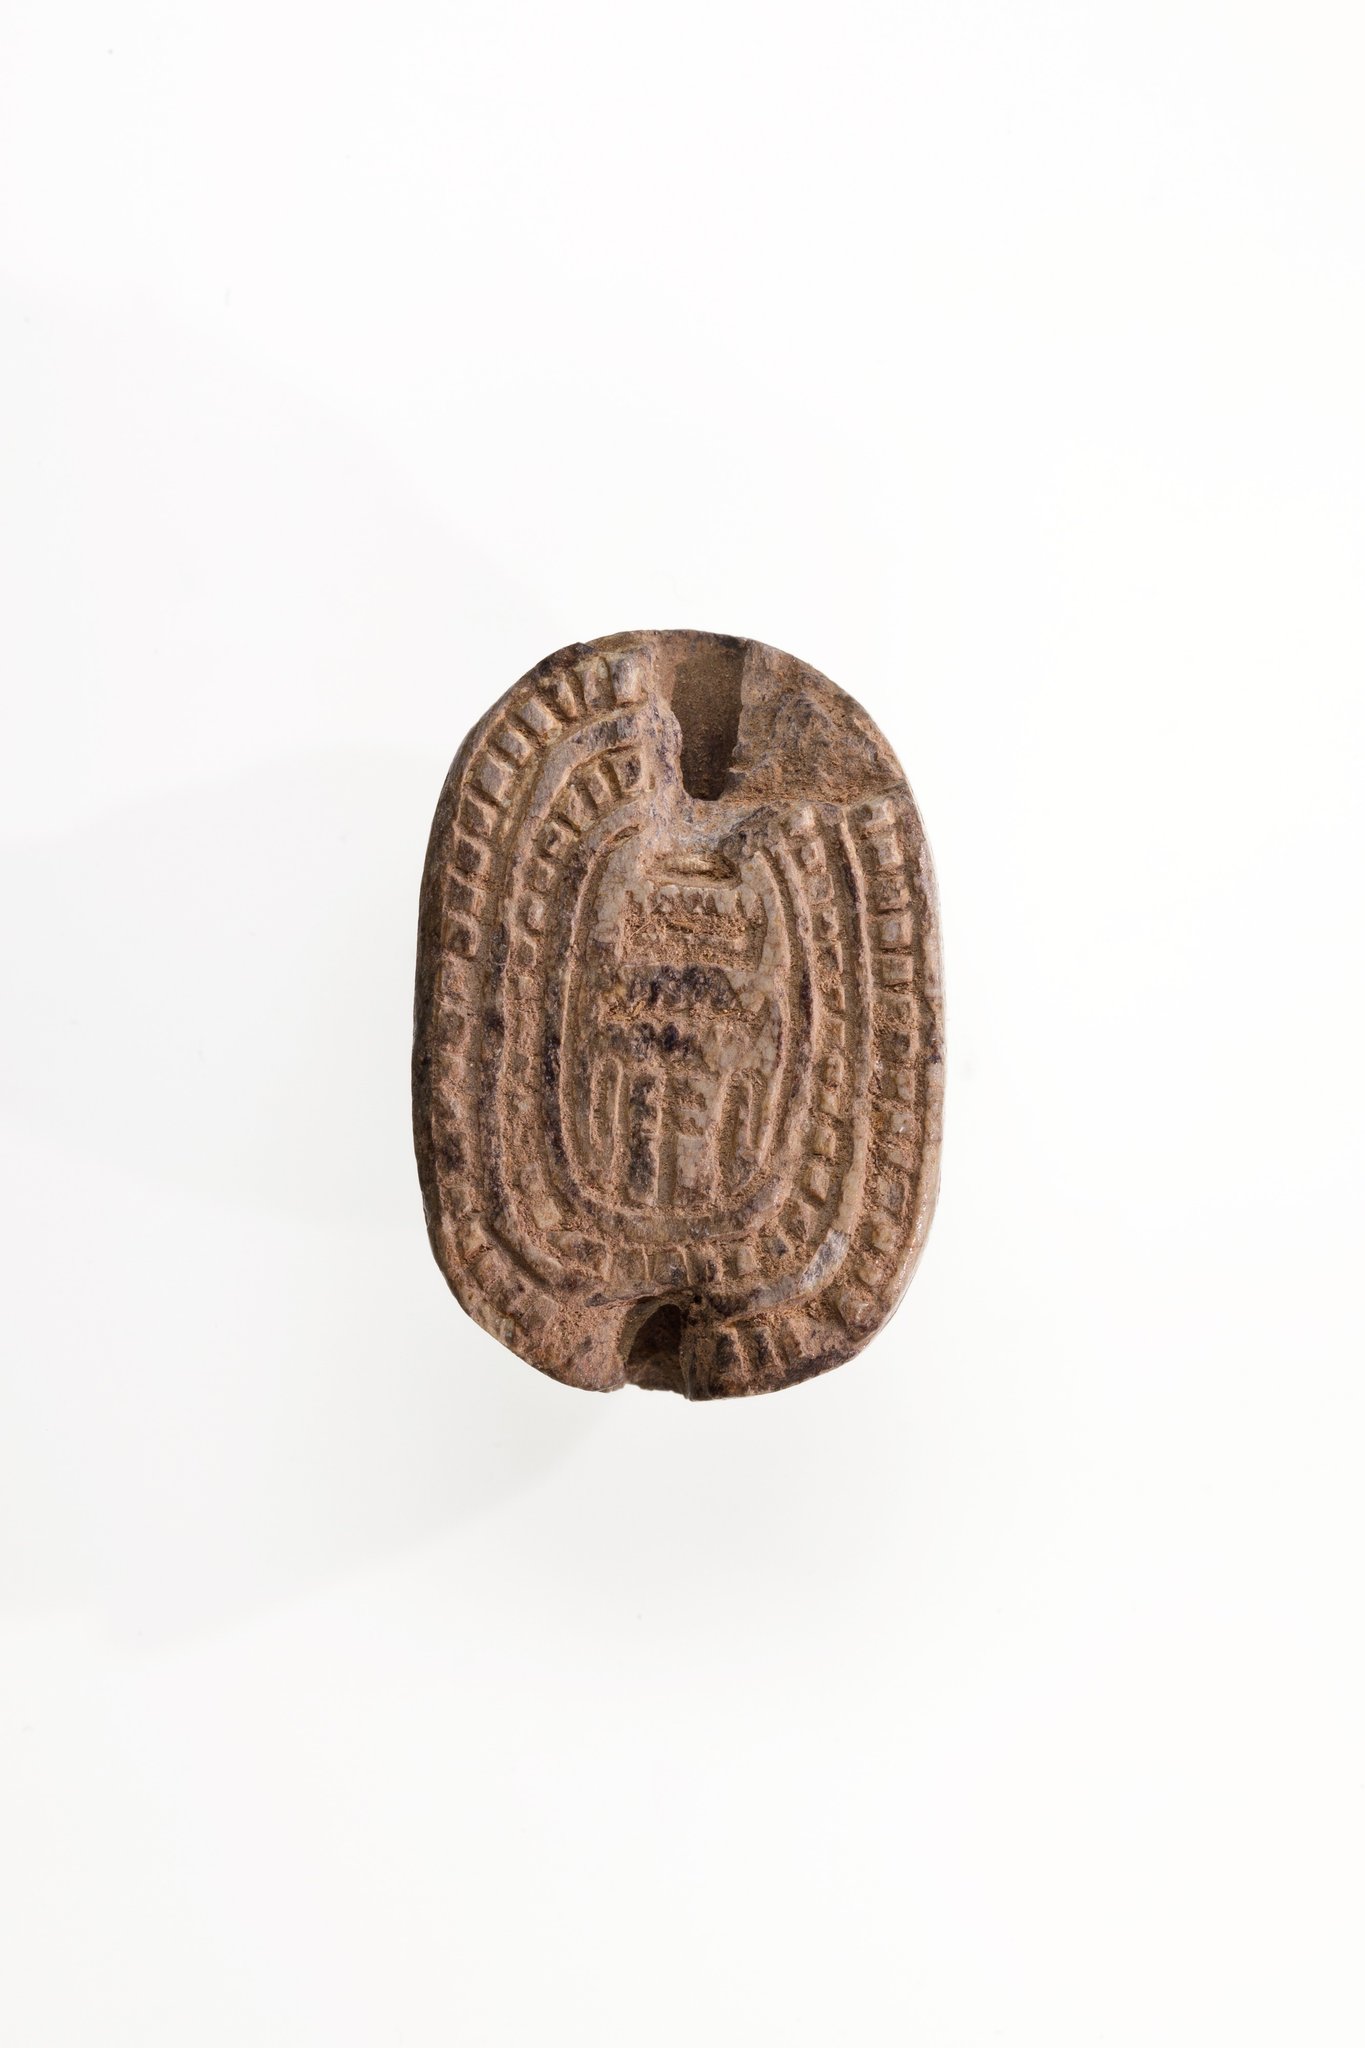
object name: scarab, pseudo inscription in oval, hieroglyph, nb, mn, n, djed, s, rope border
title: Scarab Inscribed with Hieroglyphs in Rope Border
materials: stone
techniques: glazing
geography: egypt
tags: scarabs